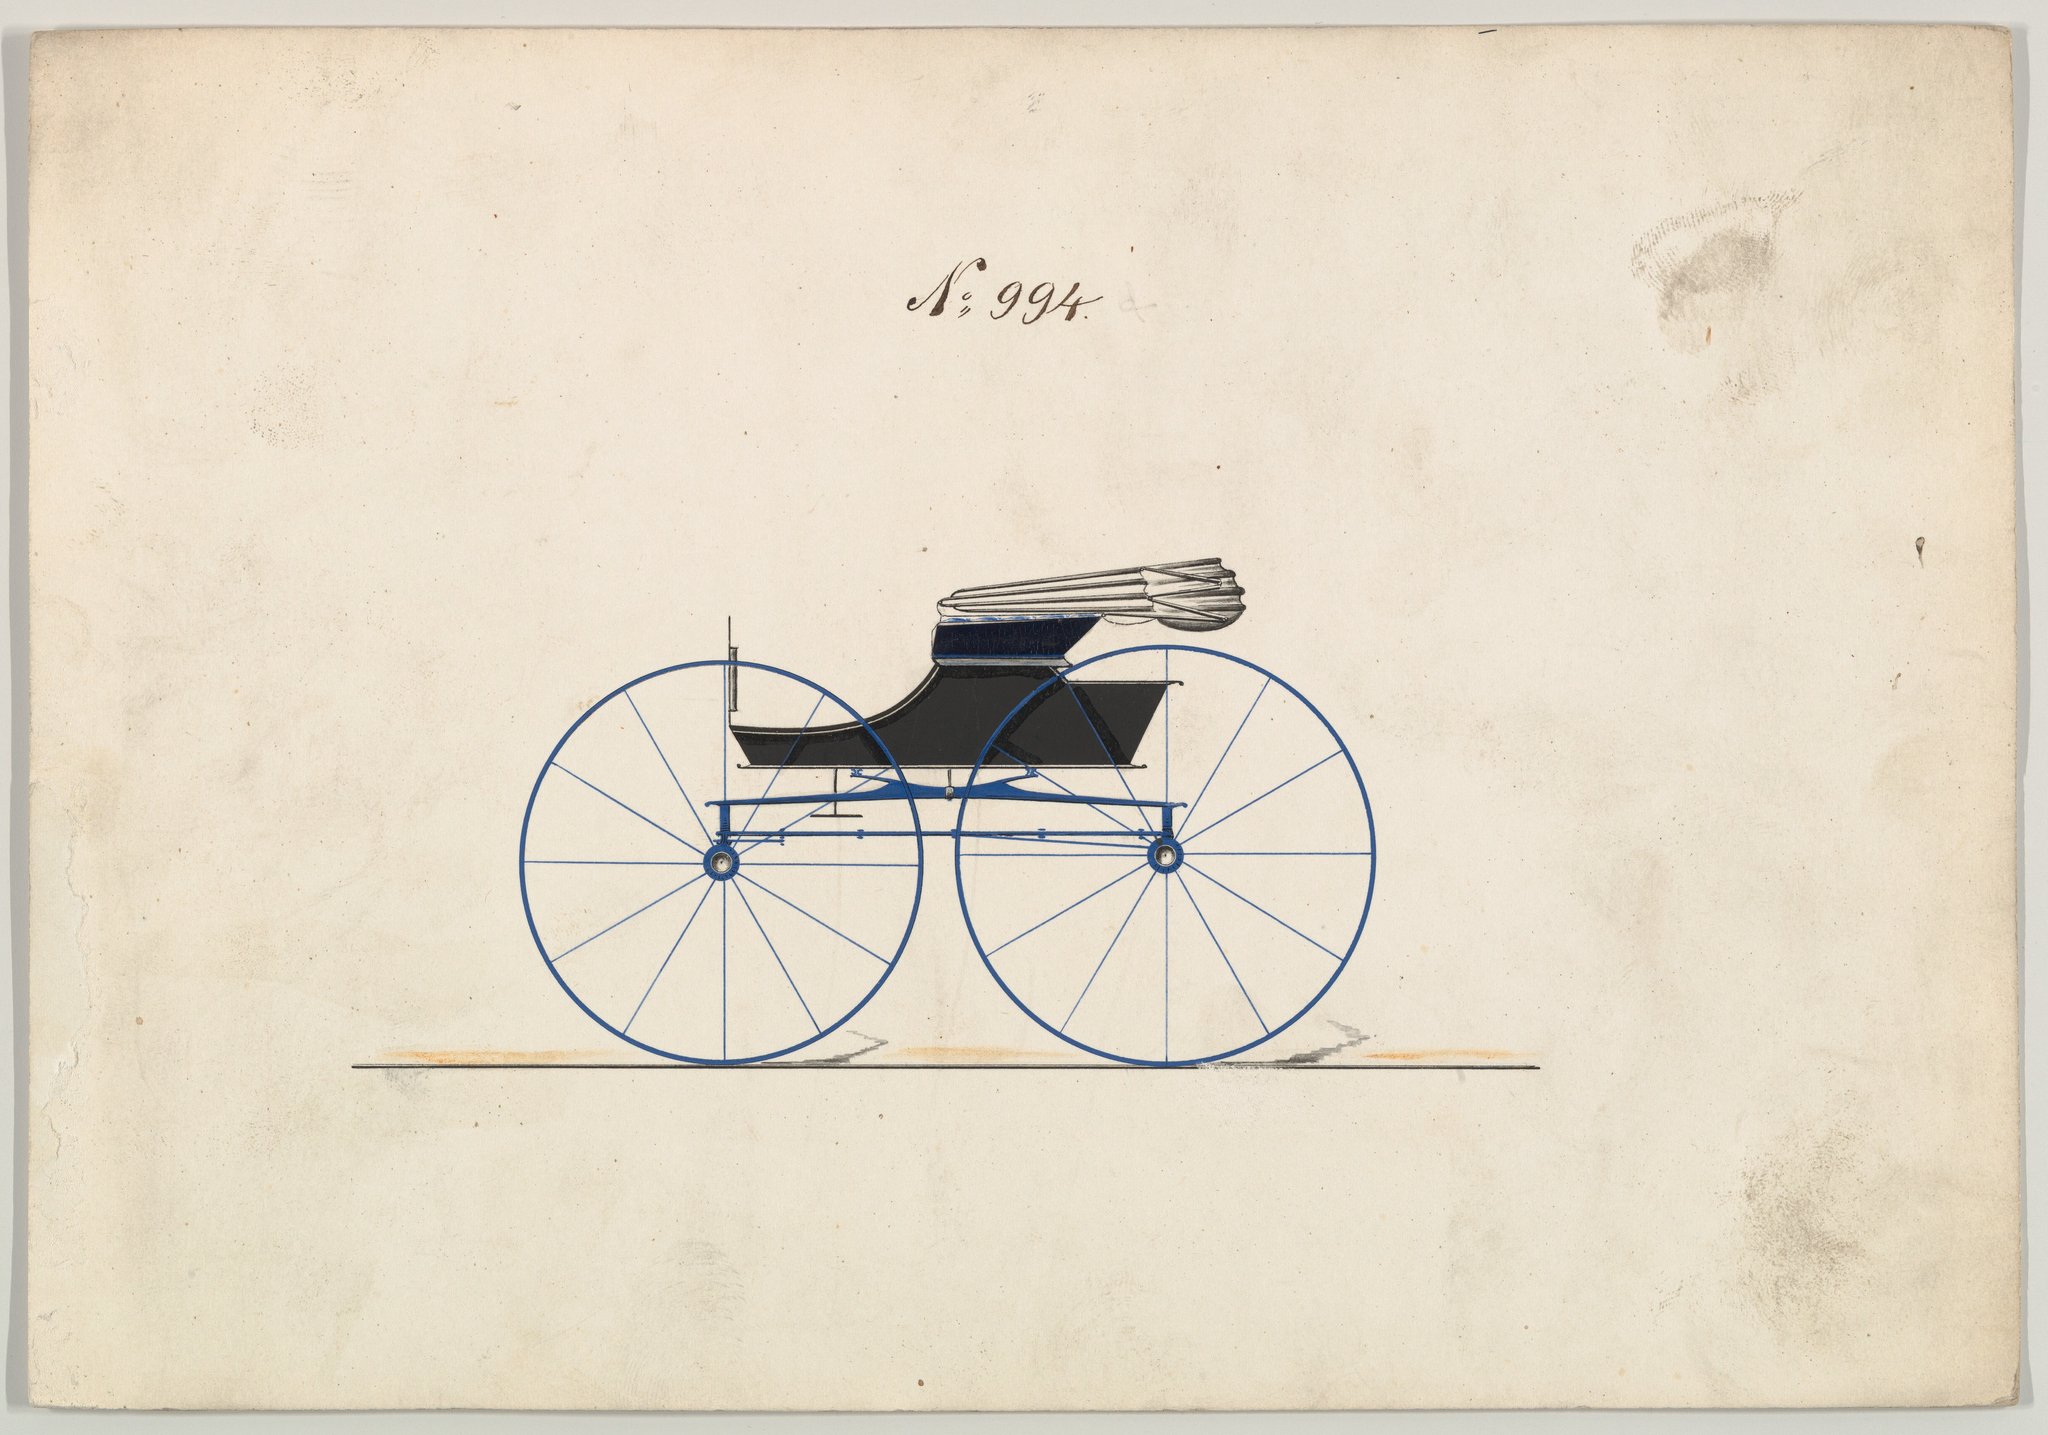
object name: drawing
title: Design for Wagon, no. 994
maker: brewster & co.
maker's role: manufacturer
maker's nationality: american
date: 1850-1870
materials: gouache, gum arabic, ink, watercolor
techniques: pen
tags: carriages